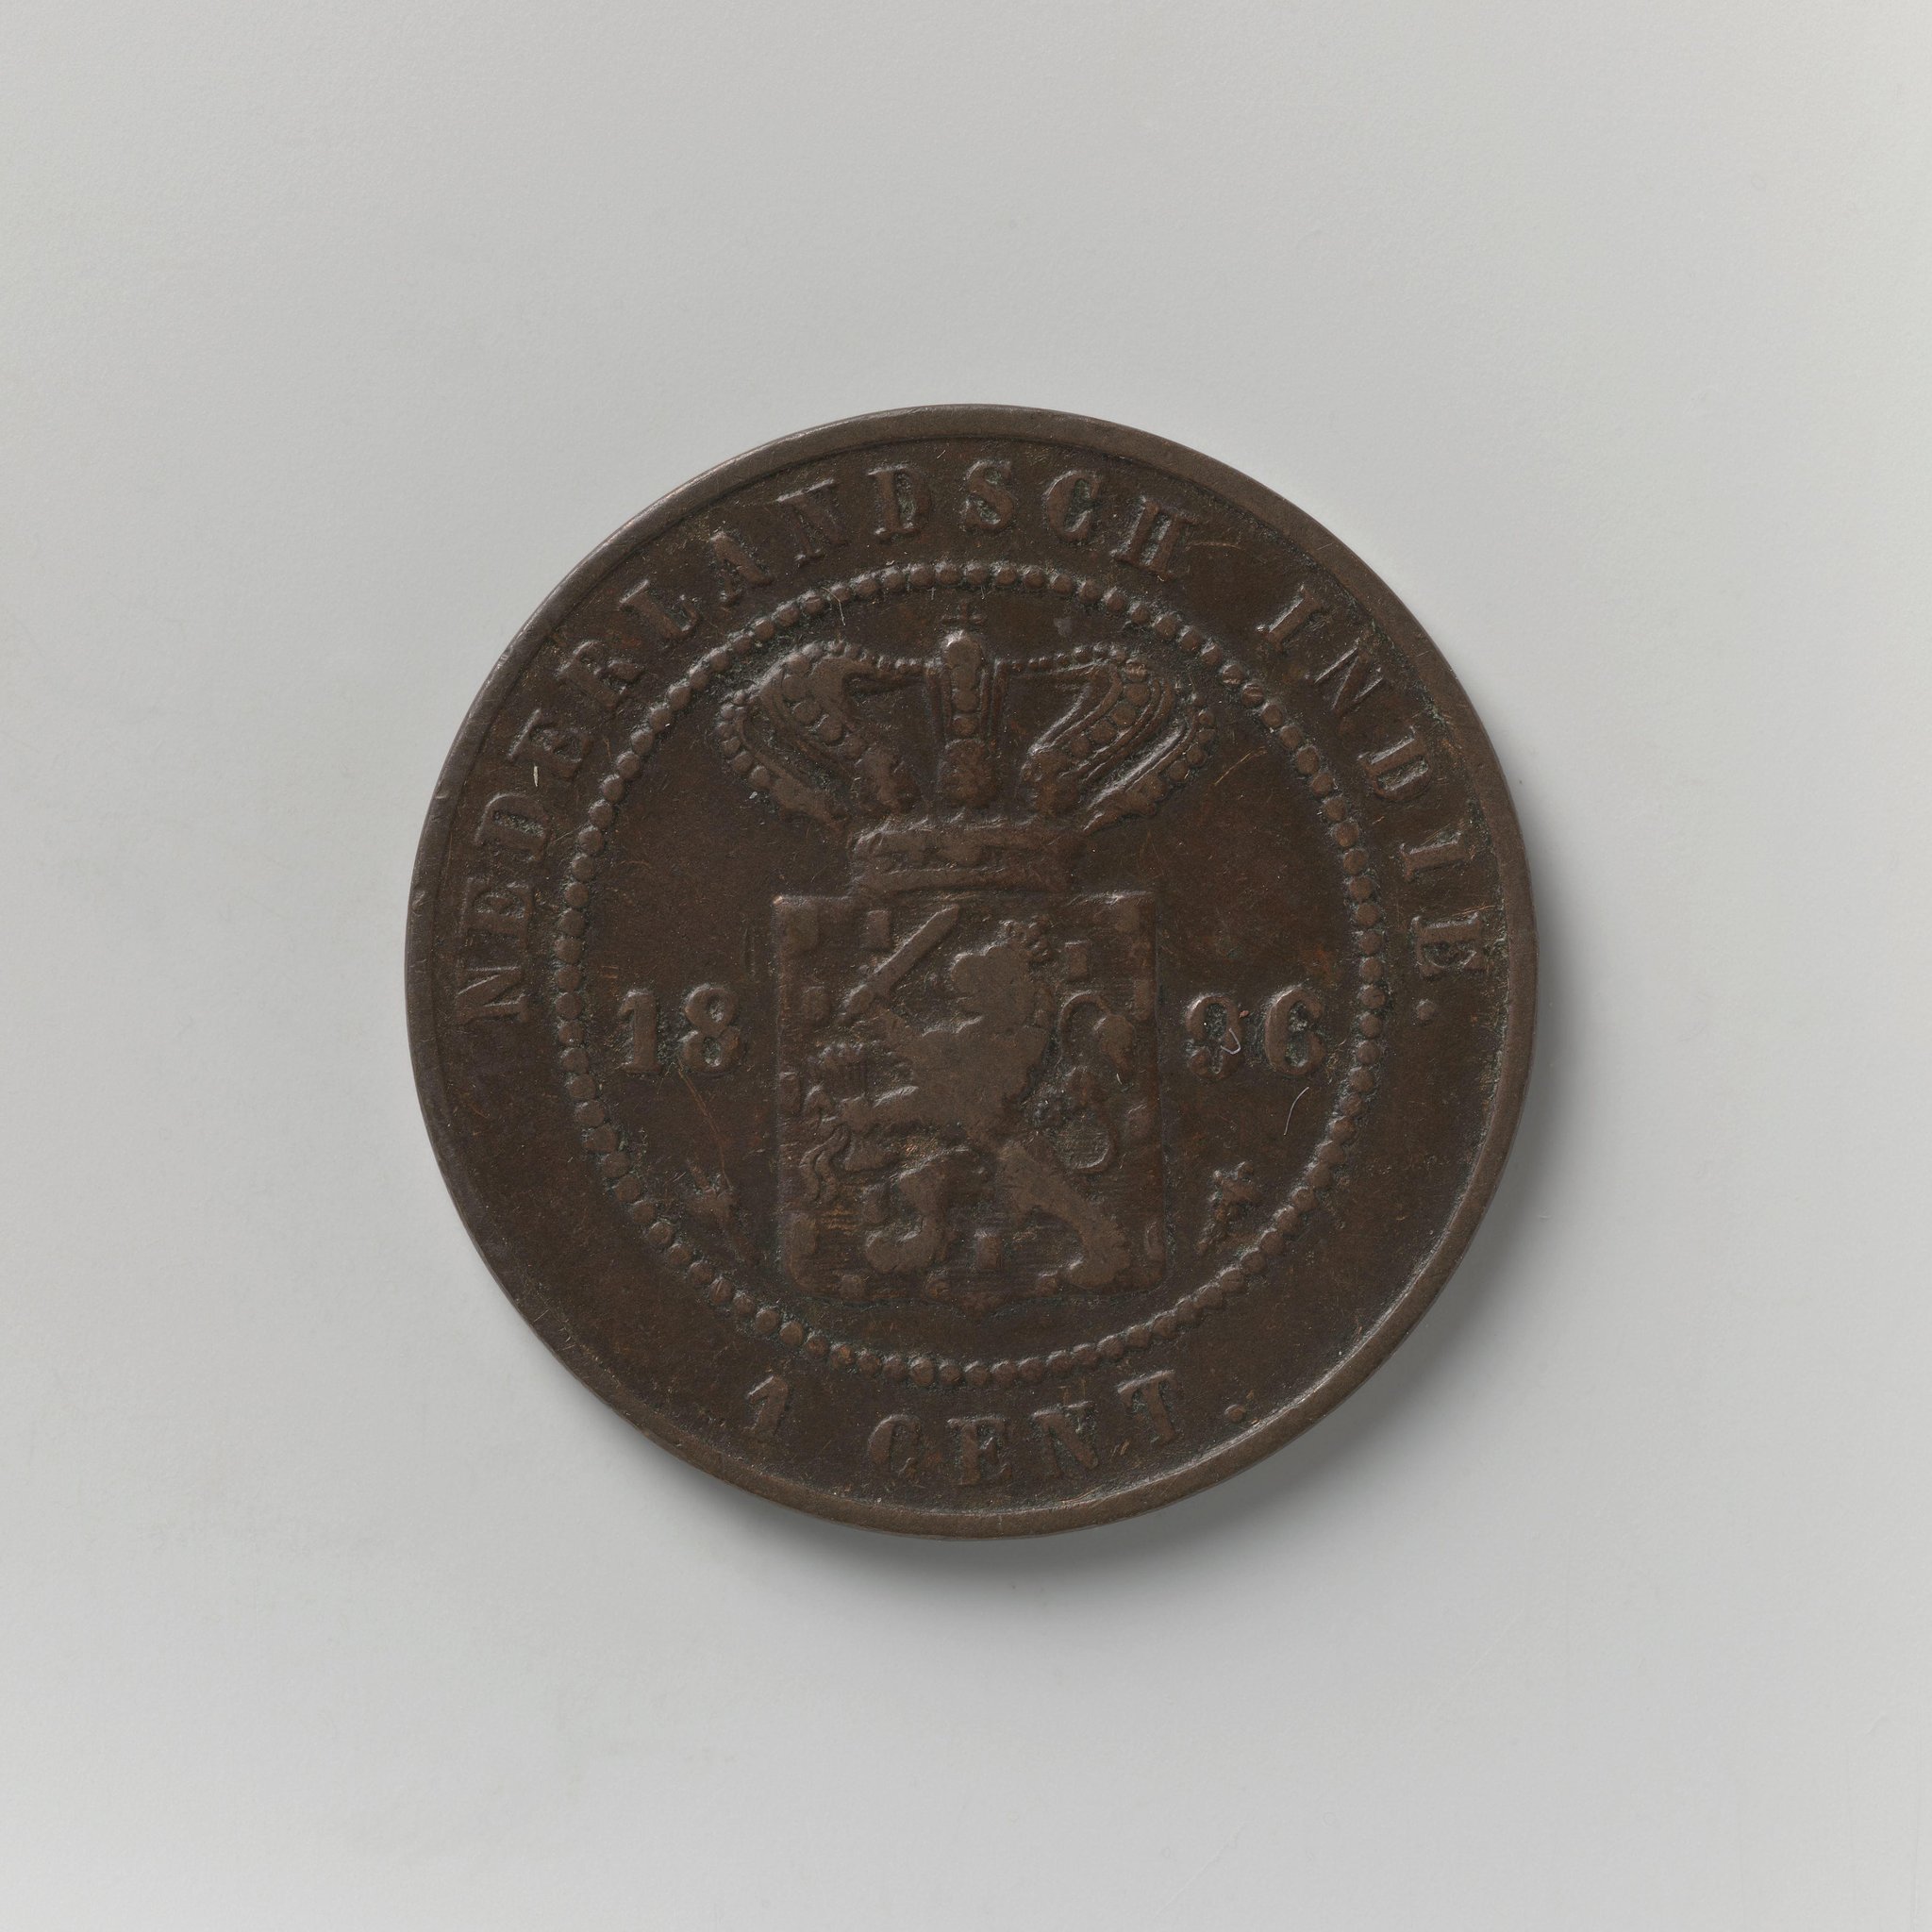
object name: coin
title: Nederlands Indië, cent,1896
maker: wilhelmina of the netherlands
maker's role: print maker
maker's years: 1880-1962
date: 1896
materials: copper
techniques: striking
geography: utrecht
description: Koperen munt. Voorzijde: tussen jaartal gekroond rijkswapenschild. Boven kroon landsaanduiding en onder wapenschild waarde-aanduiding. Keerzijde: tweeregelig Maleis opschrift in Arabische tekens, waaromheen omschrift in het Javaans. Gladde rand.